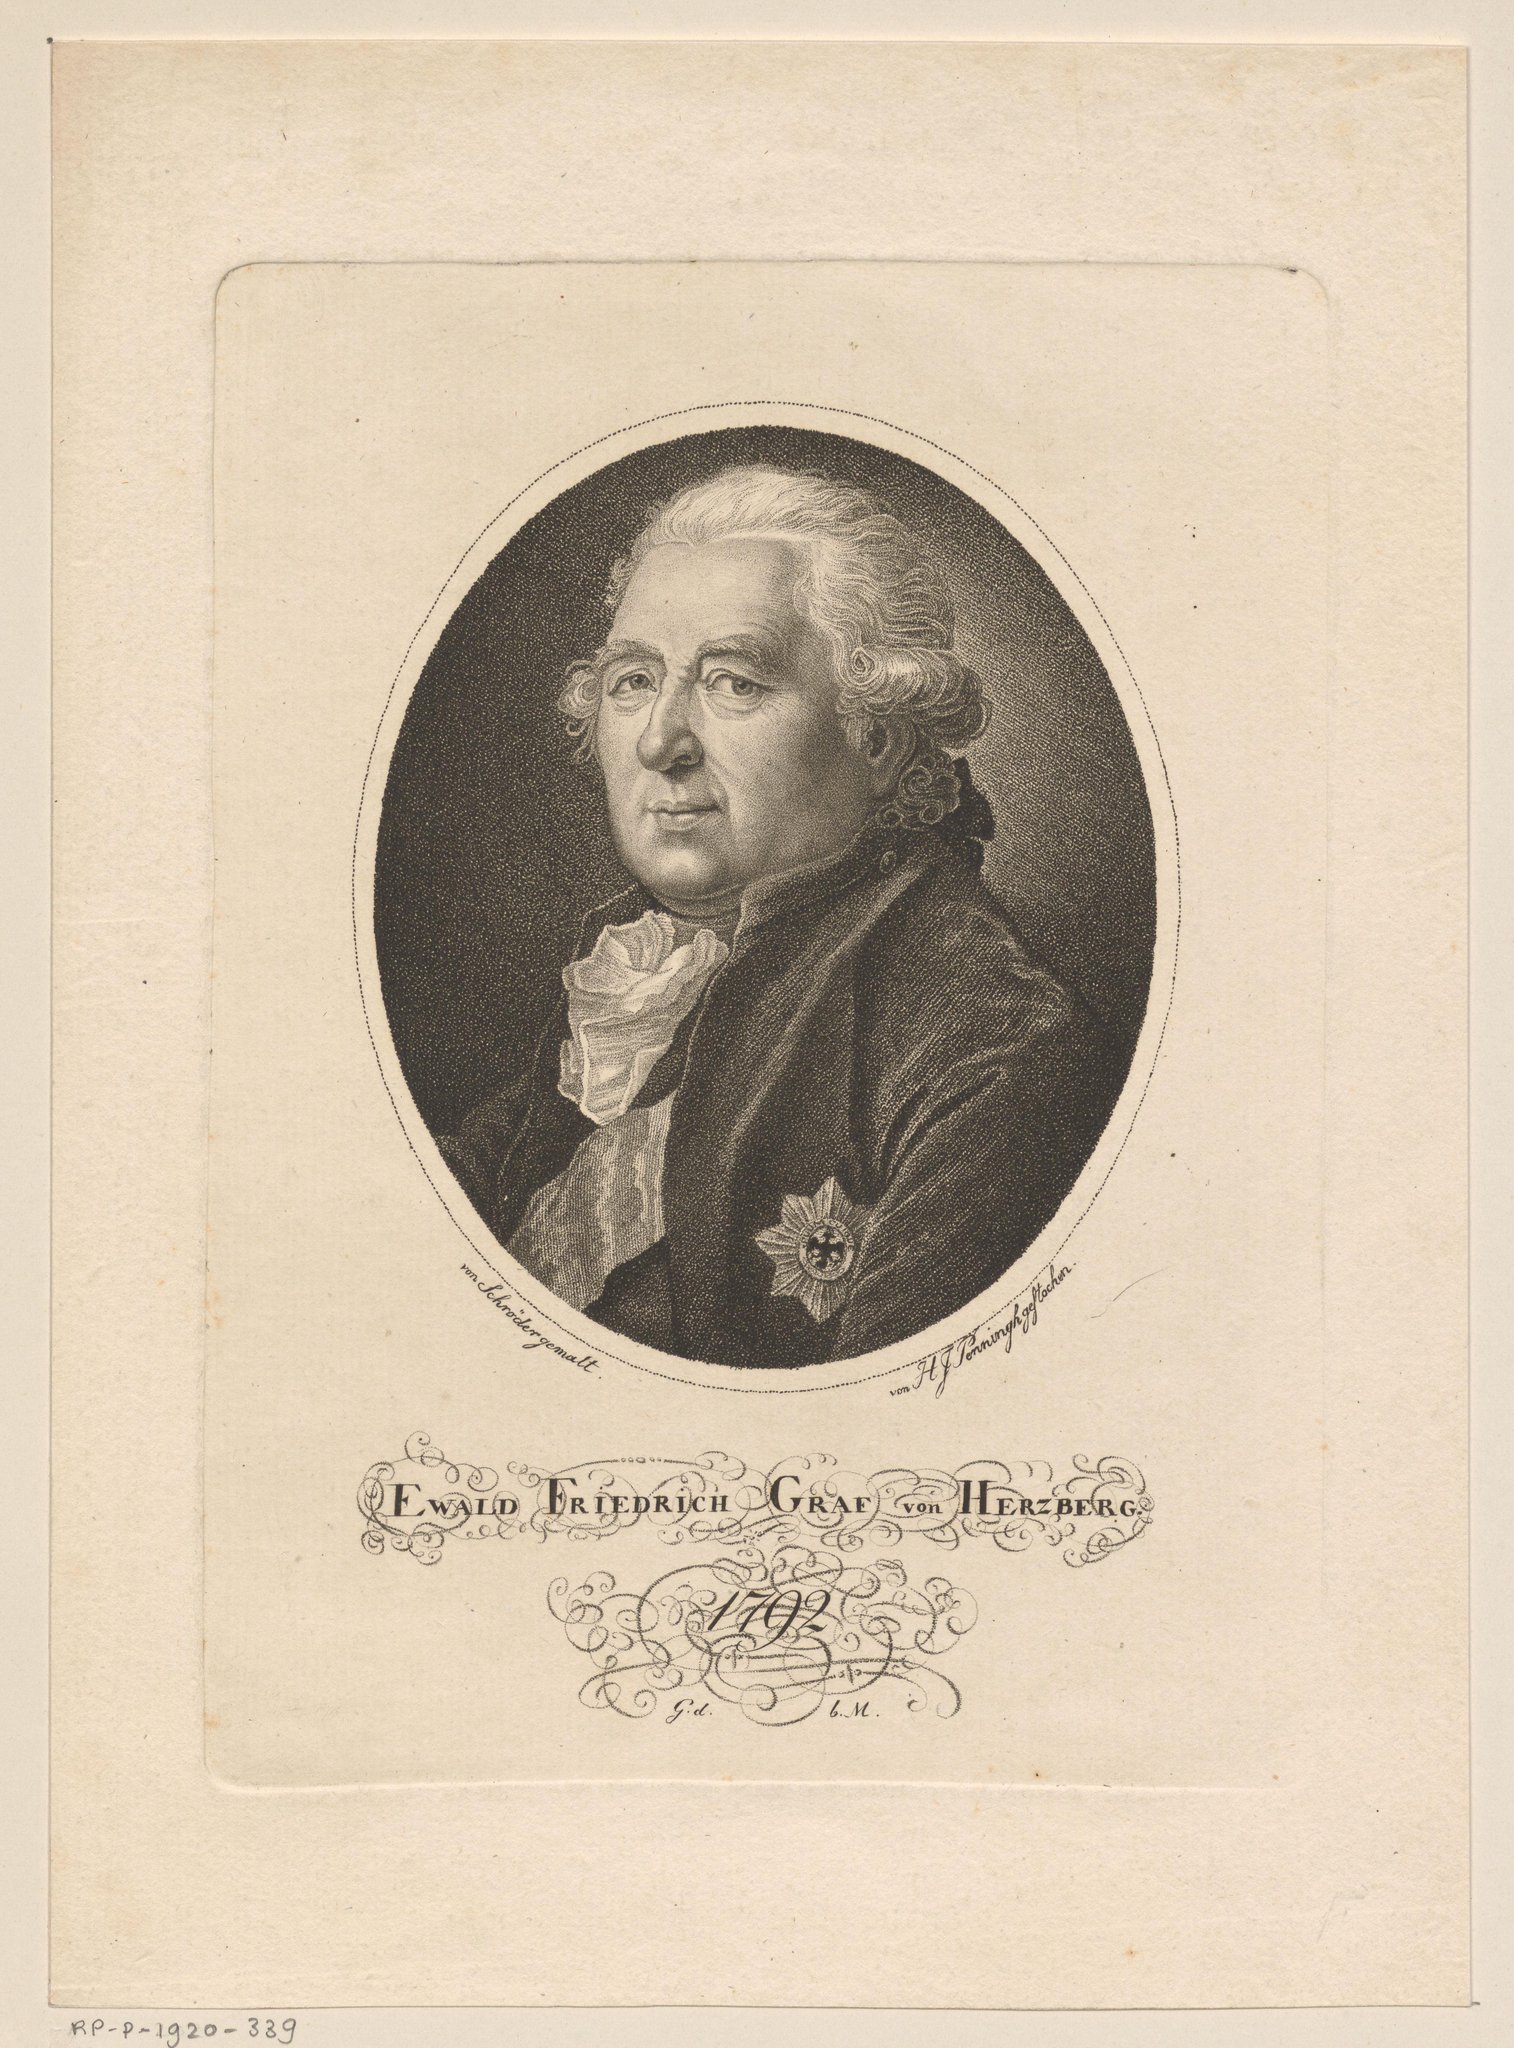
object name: print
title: Portret van Ewald Friedrich von Hertzberg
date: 1792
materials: paper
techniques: engraving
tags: berlin, ewald friedrich von hertzberg (graaf), historical persons, politician, e.g. party leader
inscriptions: collector's mark: Lugt 2228